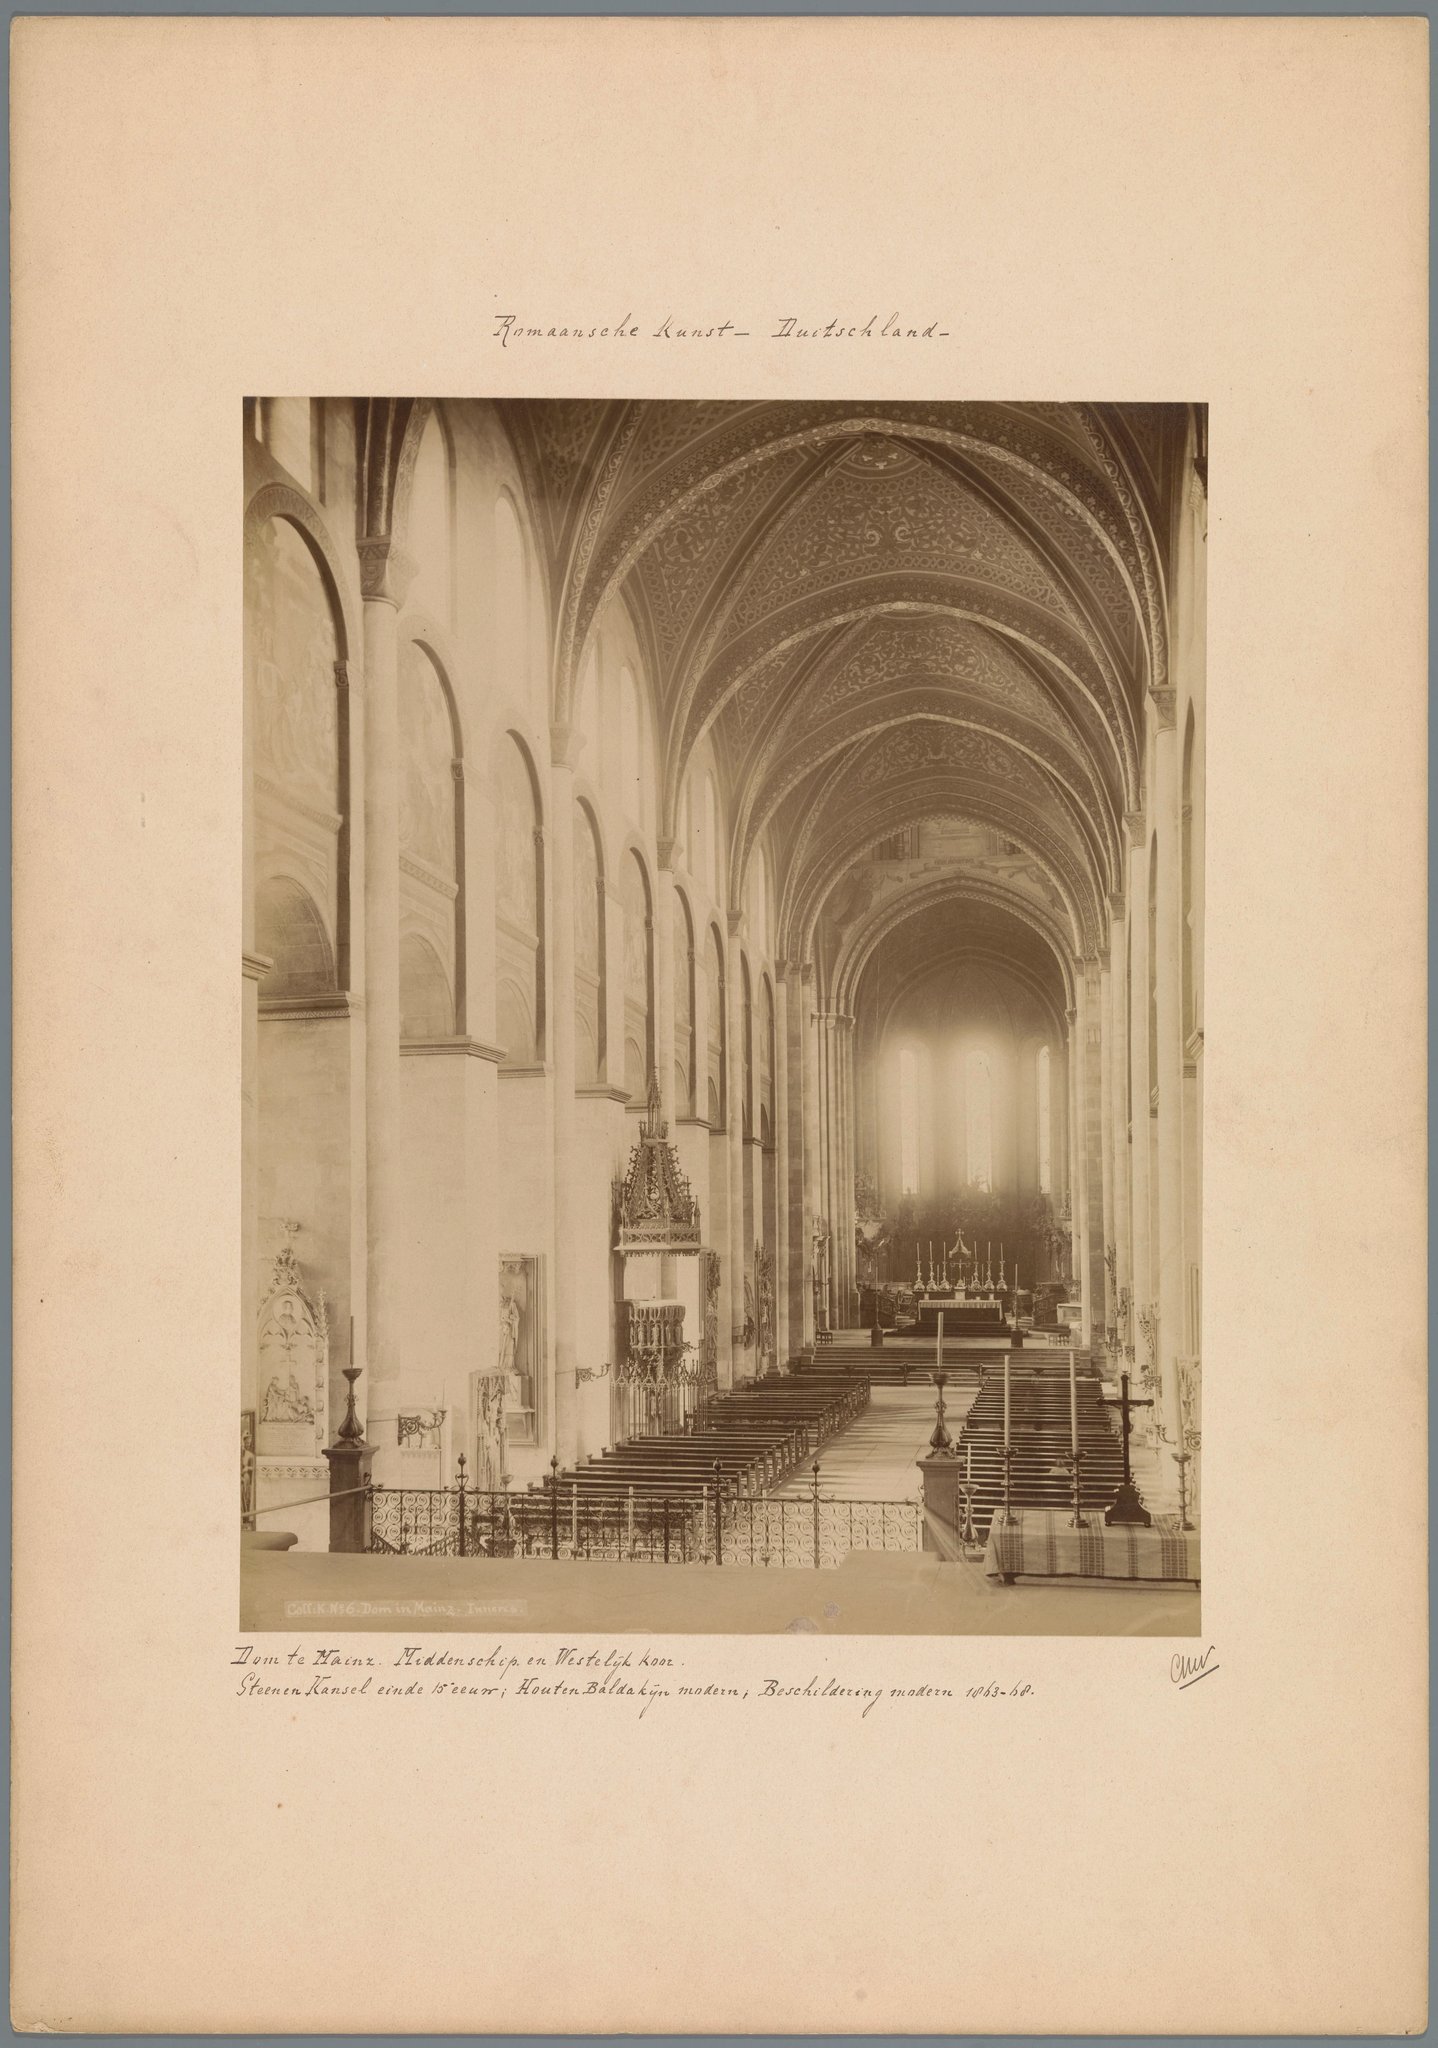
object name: photograph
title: Dom in Mainz. Inneres.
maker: Anonymous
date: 1875-1900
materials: cardboard, photographic support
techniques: albumen print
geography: mainz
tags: parts of church interior: nave, pulpit, ambo, chancel, parts of church interior: choir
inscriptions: inscription: ‘CWN.’, collector's mark: ‘INSTITUUT VOOR KUNST- NIJVERHEIDSONDERWIJS GABRIËL METSUSTRAAT No. 16. AMSTERDAM’, collector's mark: ‘KUNSTNIJVERHEIDSCHOOL QUELLINUS AMSTERDAM FRANS HALSSTRAAT 14.’, number: ‘No 6’, inscription: ‘Romaansche Kunst - Duitschland. Dom te Mainz (...) Beschildering modern 1863-68.’, inscription: ‘Coll:K’